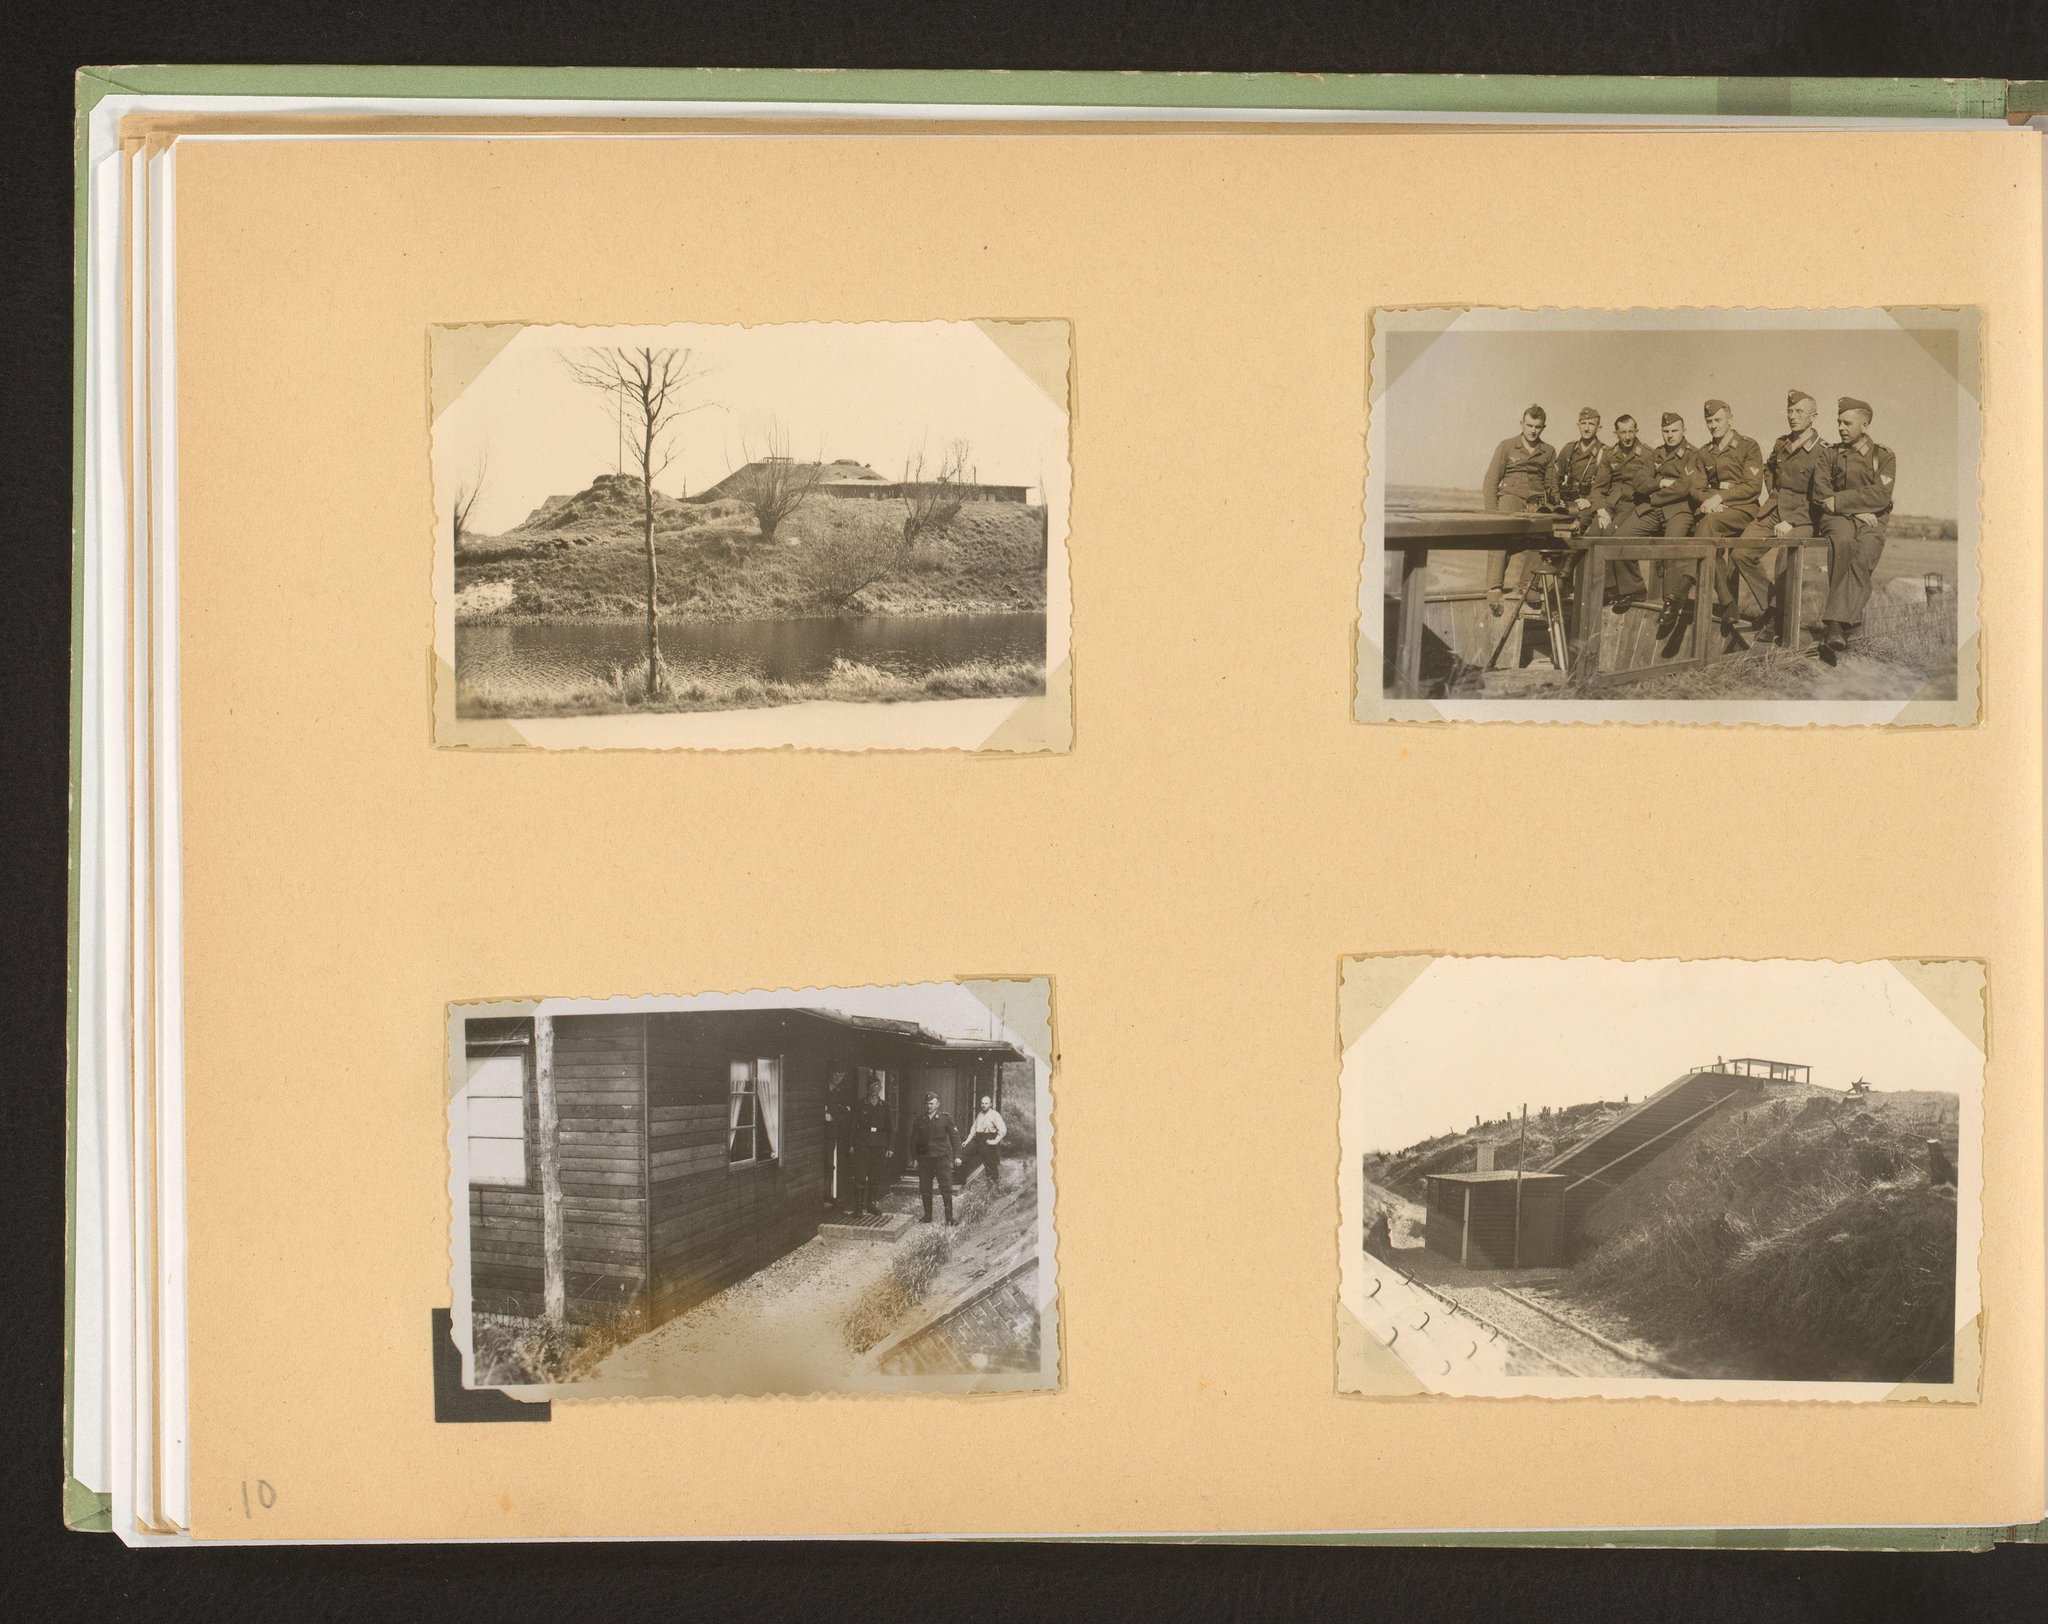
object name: album leaf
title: Bunkerbewaking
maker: Anonymous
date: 1940-1944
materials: paper, photographic support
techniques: gelatin silver print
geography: netherlands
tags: dune coast, the company, the unit, the troop ~ military service, permanent fortifications, netherlands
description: Albumblad met vier foto's van de bunkers en de Duitse bemanning van de bunkers aan de Noordzeekust. Onderdeel van het fotoalbum Bewaking bunkers.